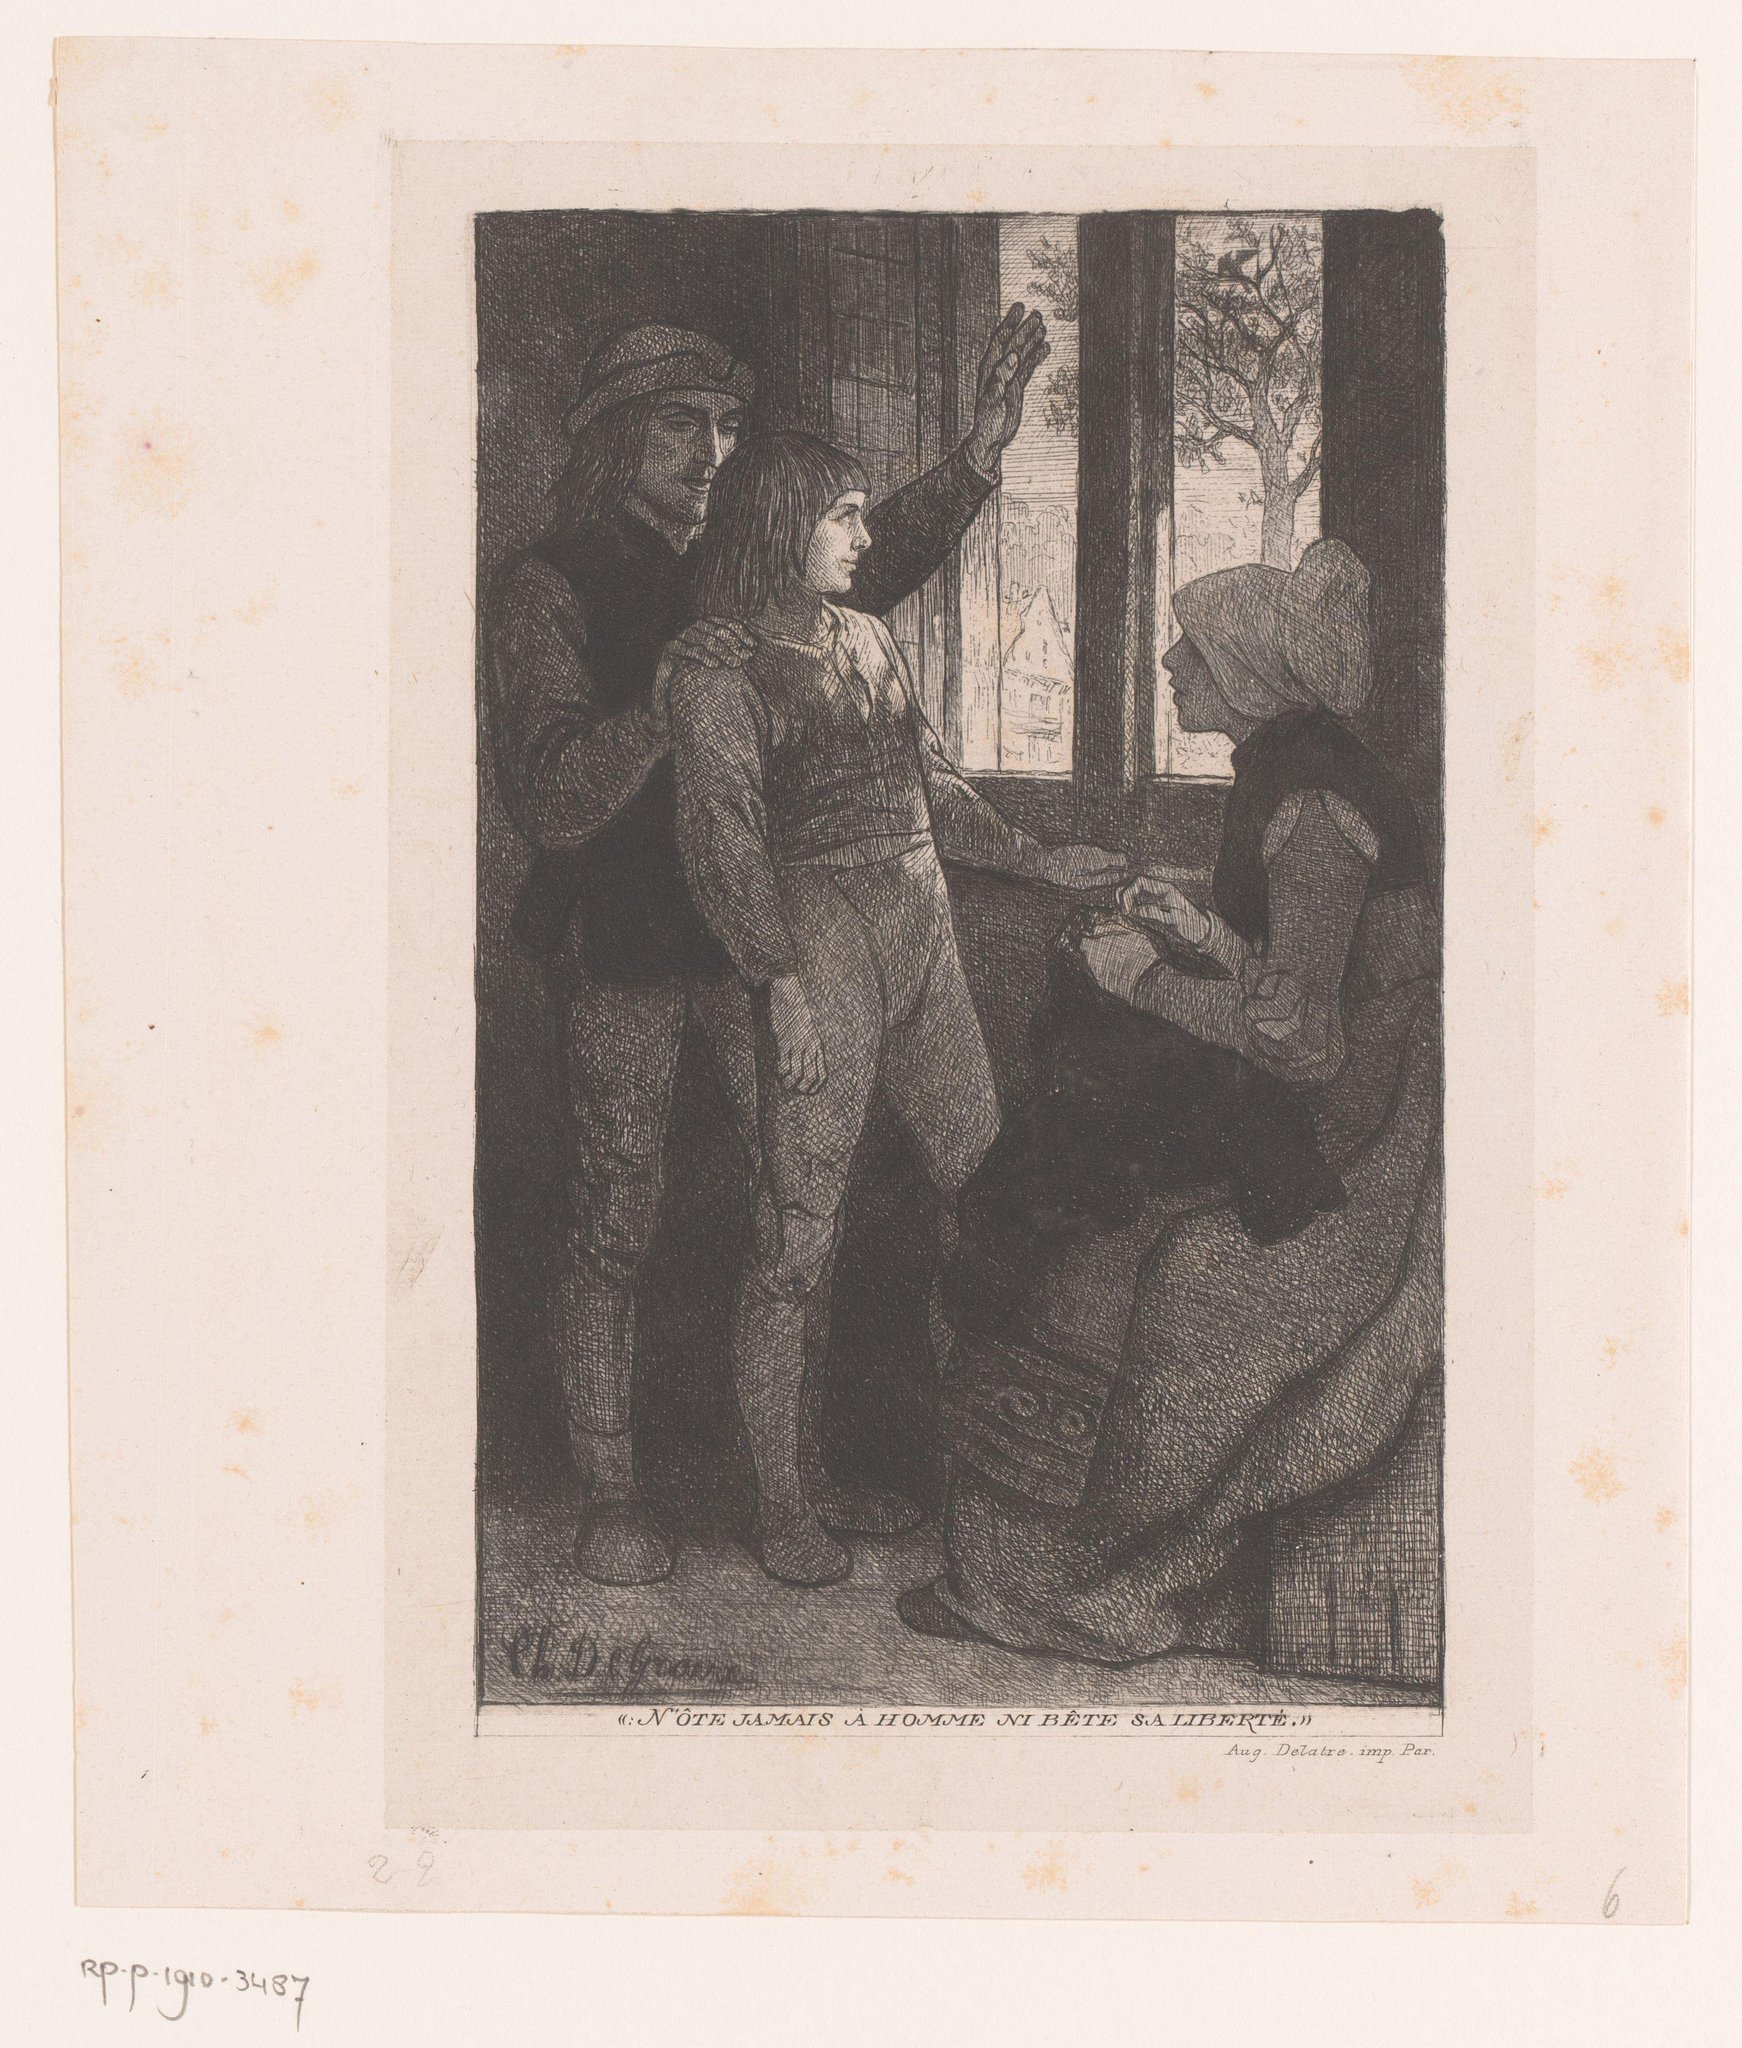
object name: book illustration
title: N'ôte jamais à homme ni bète sa liberté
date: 1867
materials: paper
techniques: etching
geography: paris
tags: parental care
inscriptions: collector's mark: Lugt 2228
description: Prent uit: Coster, Charles de. Le légende et les aventures héroiques, joyeuses et glorieuses d'Ulenspiegel et de Lamme Goedzak au pays de Flandres et ailleurs. 1e druk. Parijs: s.n., [1867].